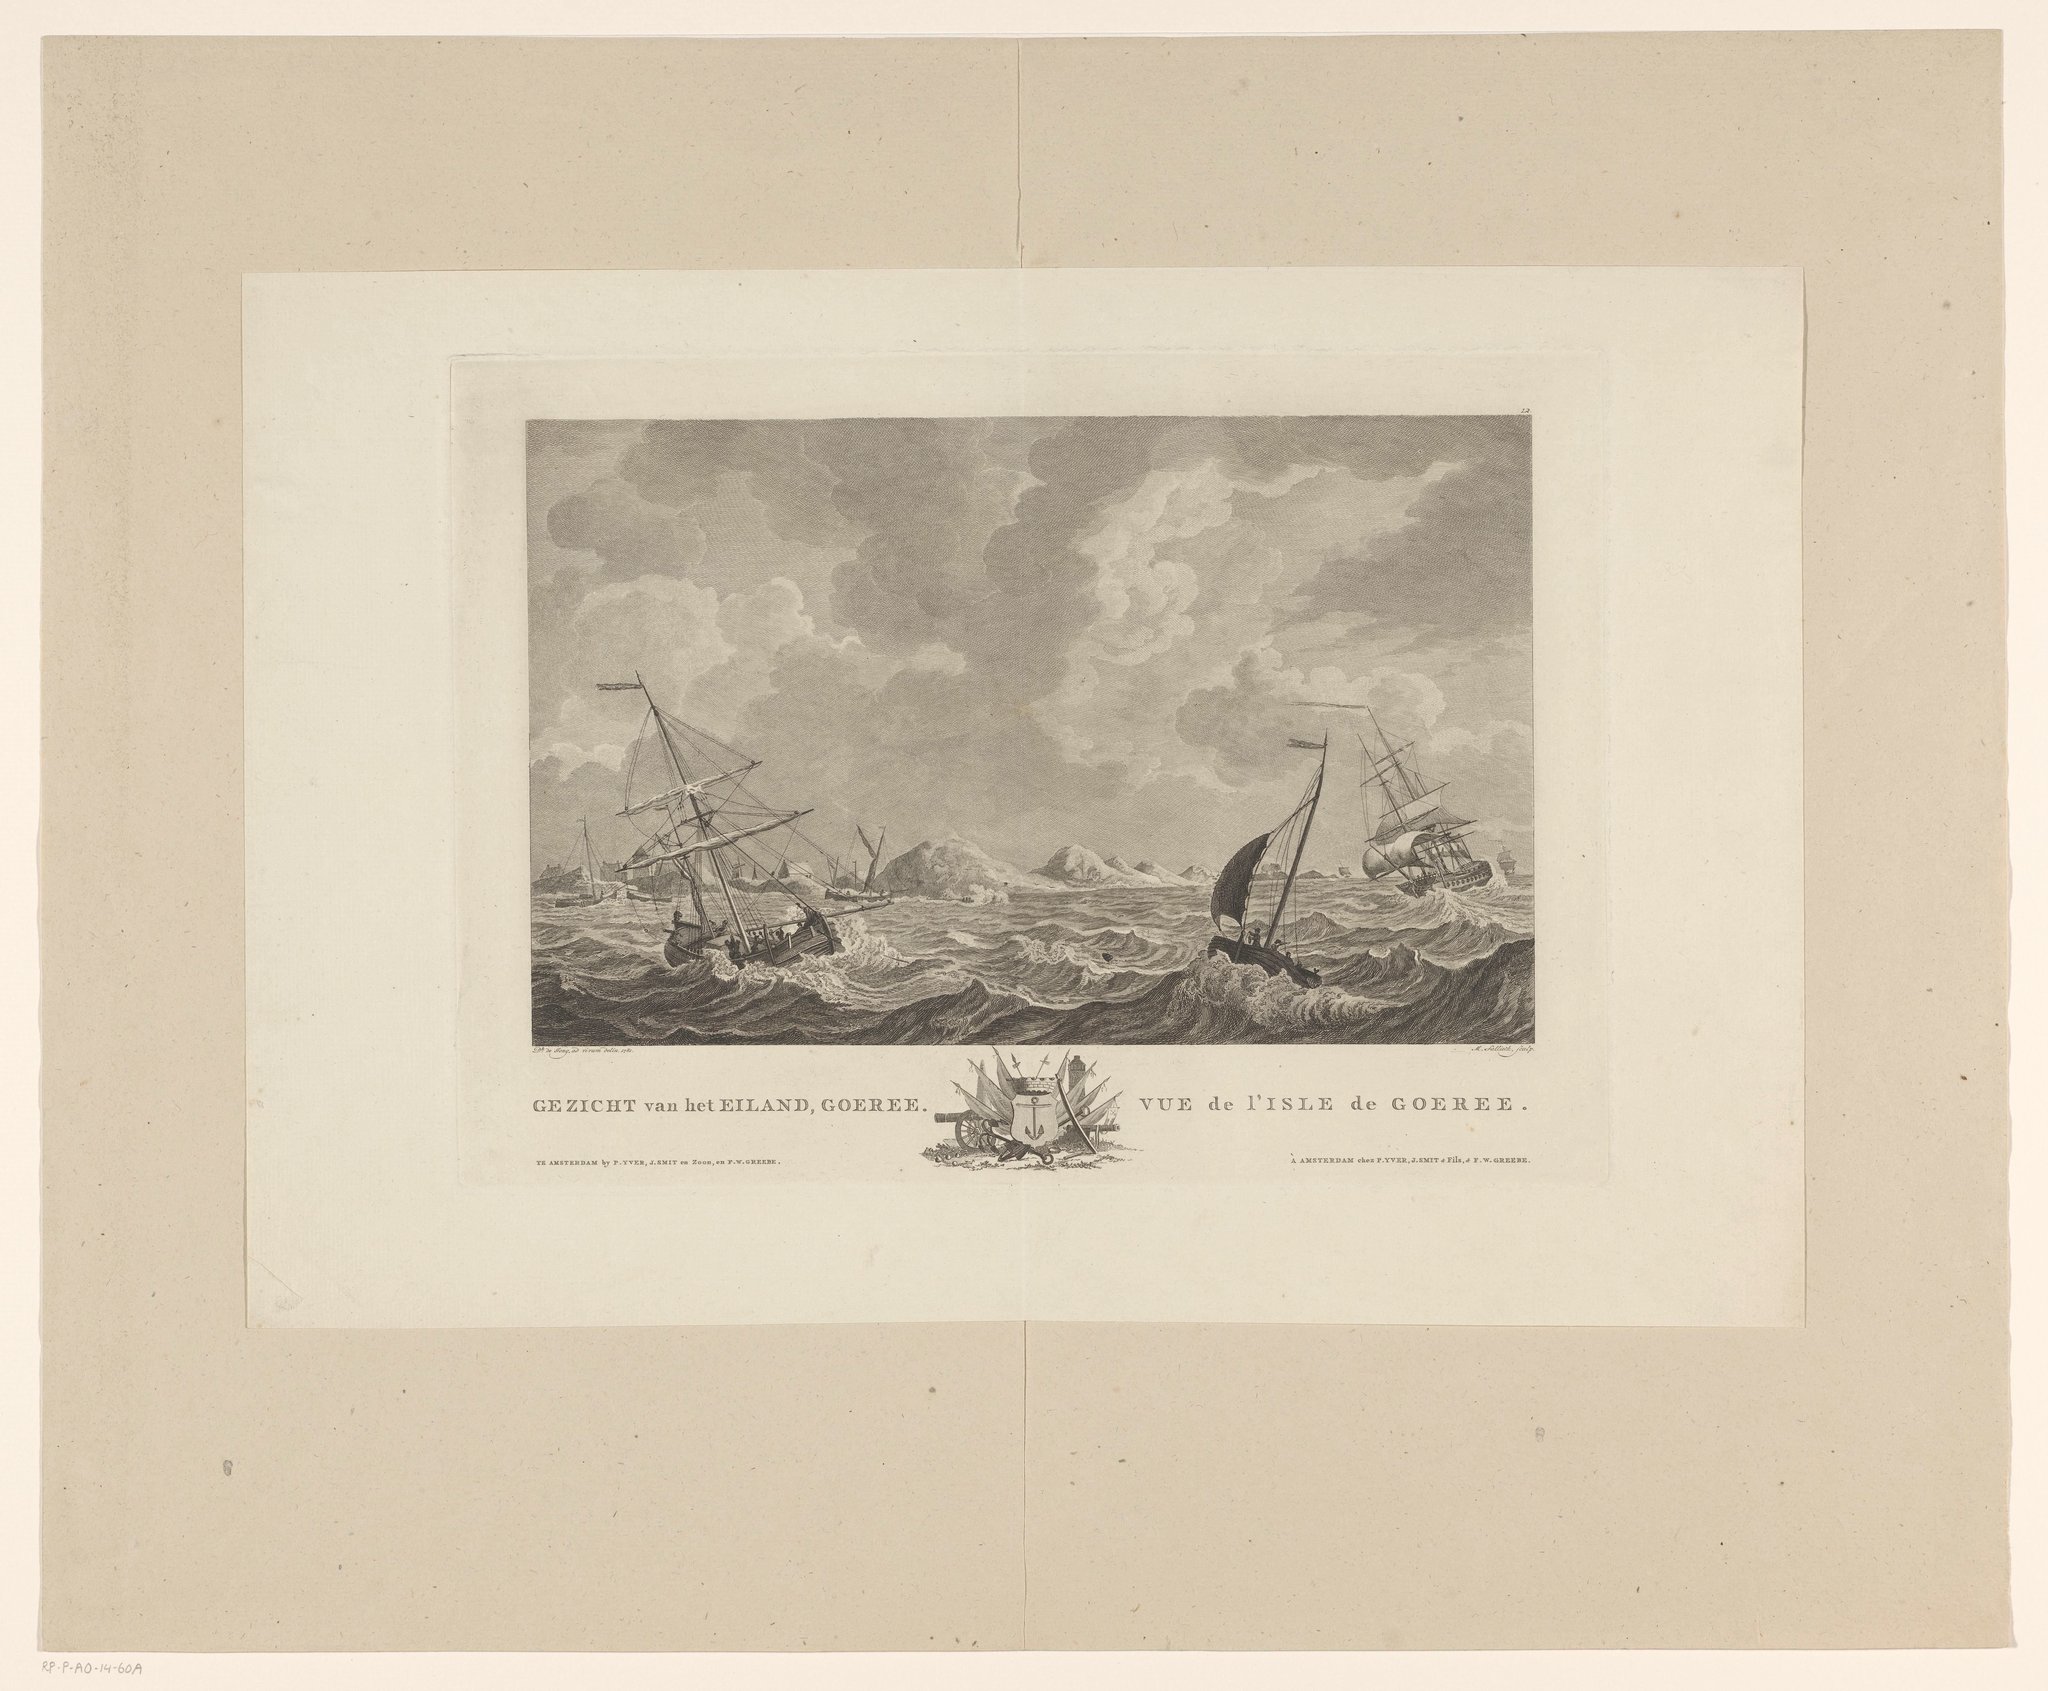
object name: print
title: Gezicht op het eiland Goeree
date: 1781-1787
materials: paper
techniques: engraving, etching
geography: amsterdam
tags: coat of arms (as symbol of the state, etc.), island, sailing-ship, sailing-boat, sea (seascape)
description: Latere staat ook gebruikt in: Aa, Cornelis van der. Atlas van de zeehavens der Bataafsche Republiek. Met derzelver beschrijvingen in XXXI kunstplaaten / Atlas van de zeehavens der Bataafsche Republiek, die van Batavia en Onrust. Mitsgaders de afbeeldingen van de haringvisscherij en de walvischvangst (…). Amsterdam: Evert Maaskamp, 1805.